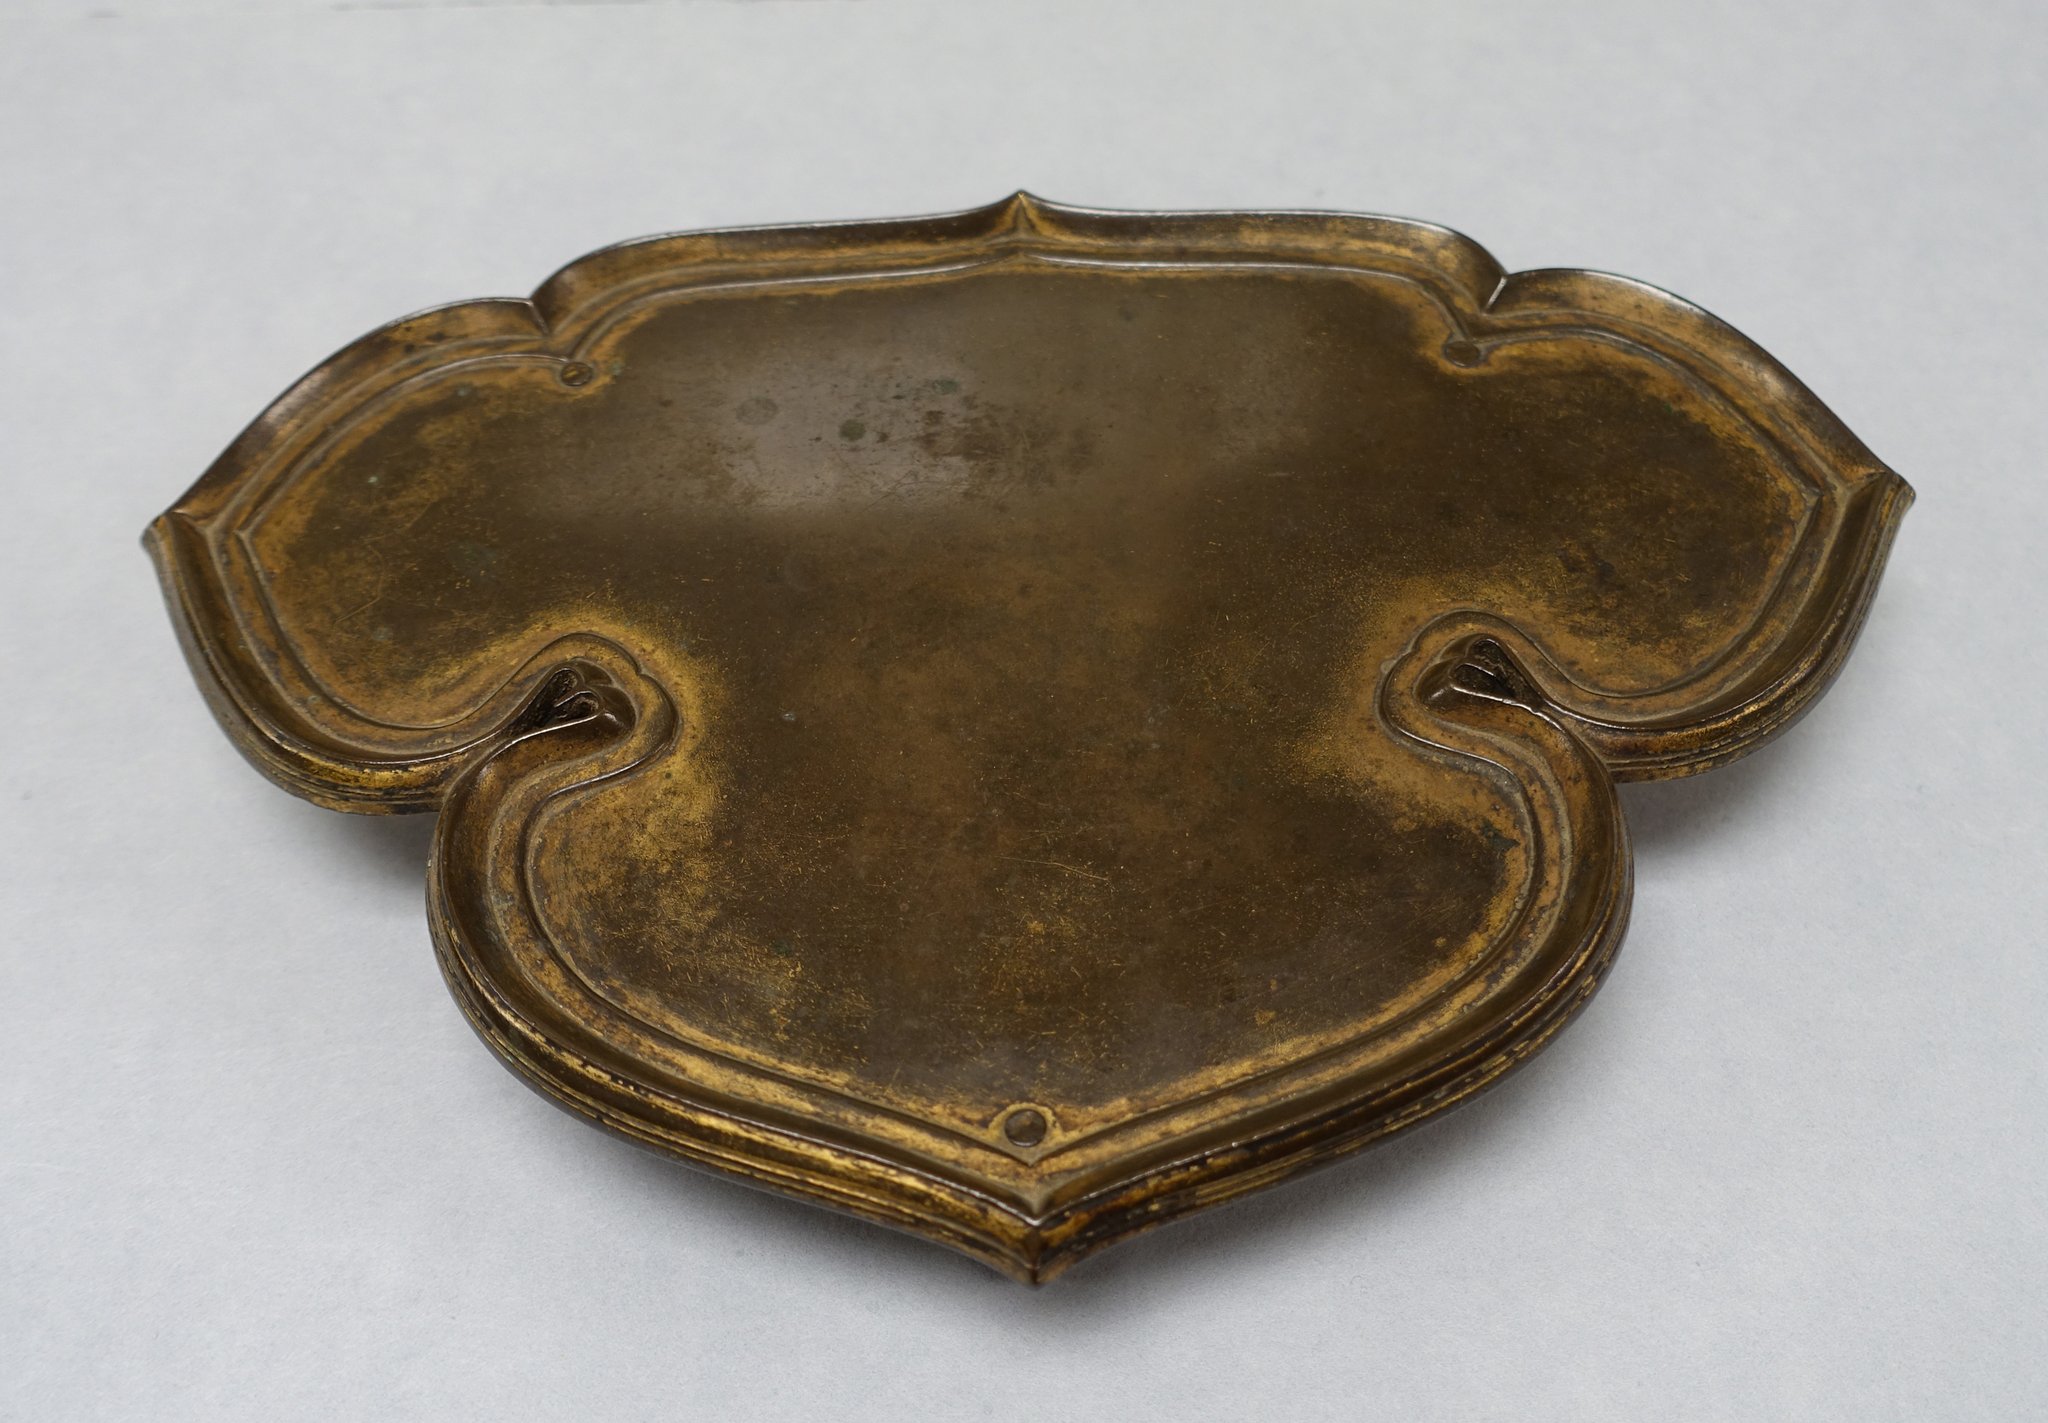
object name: stand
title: Three-Footed Stand (Kongōban) for Buddhist Ritual Implements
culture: japanese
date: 1201-1300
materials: gilt bronze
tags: buddhism